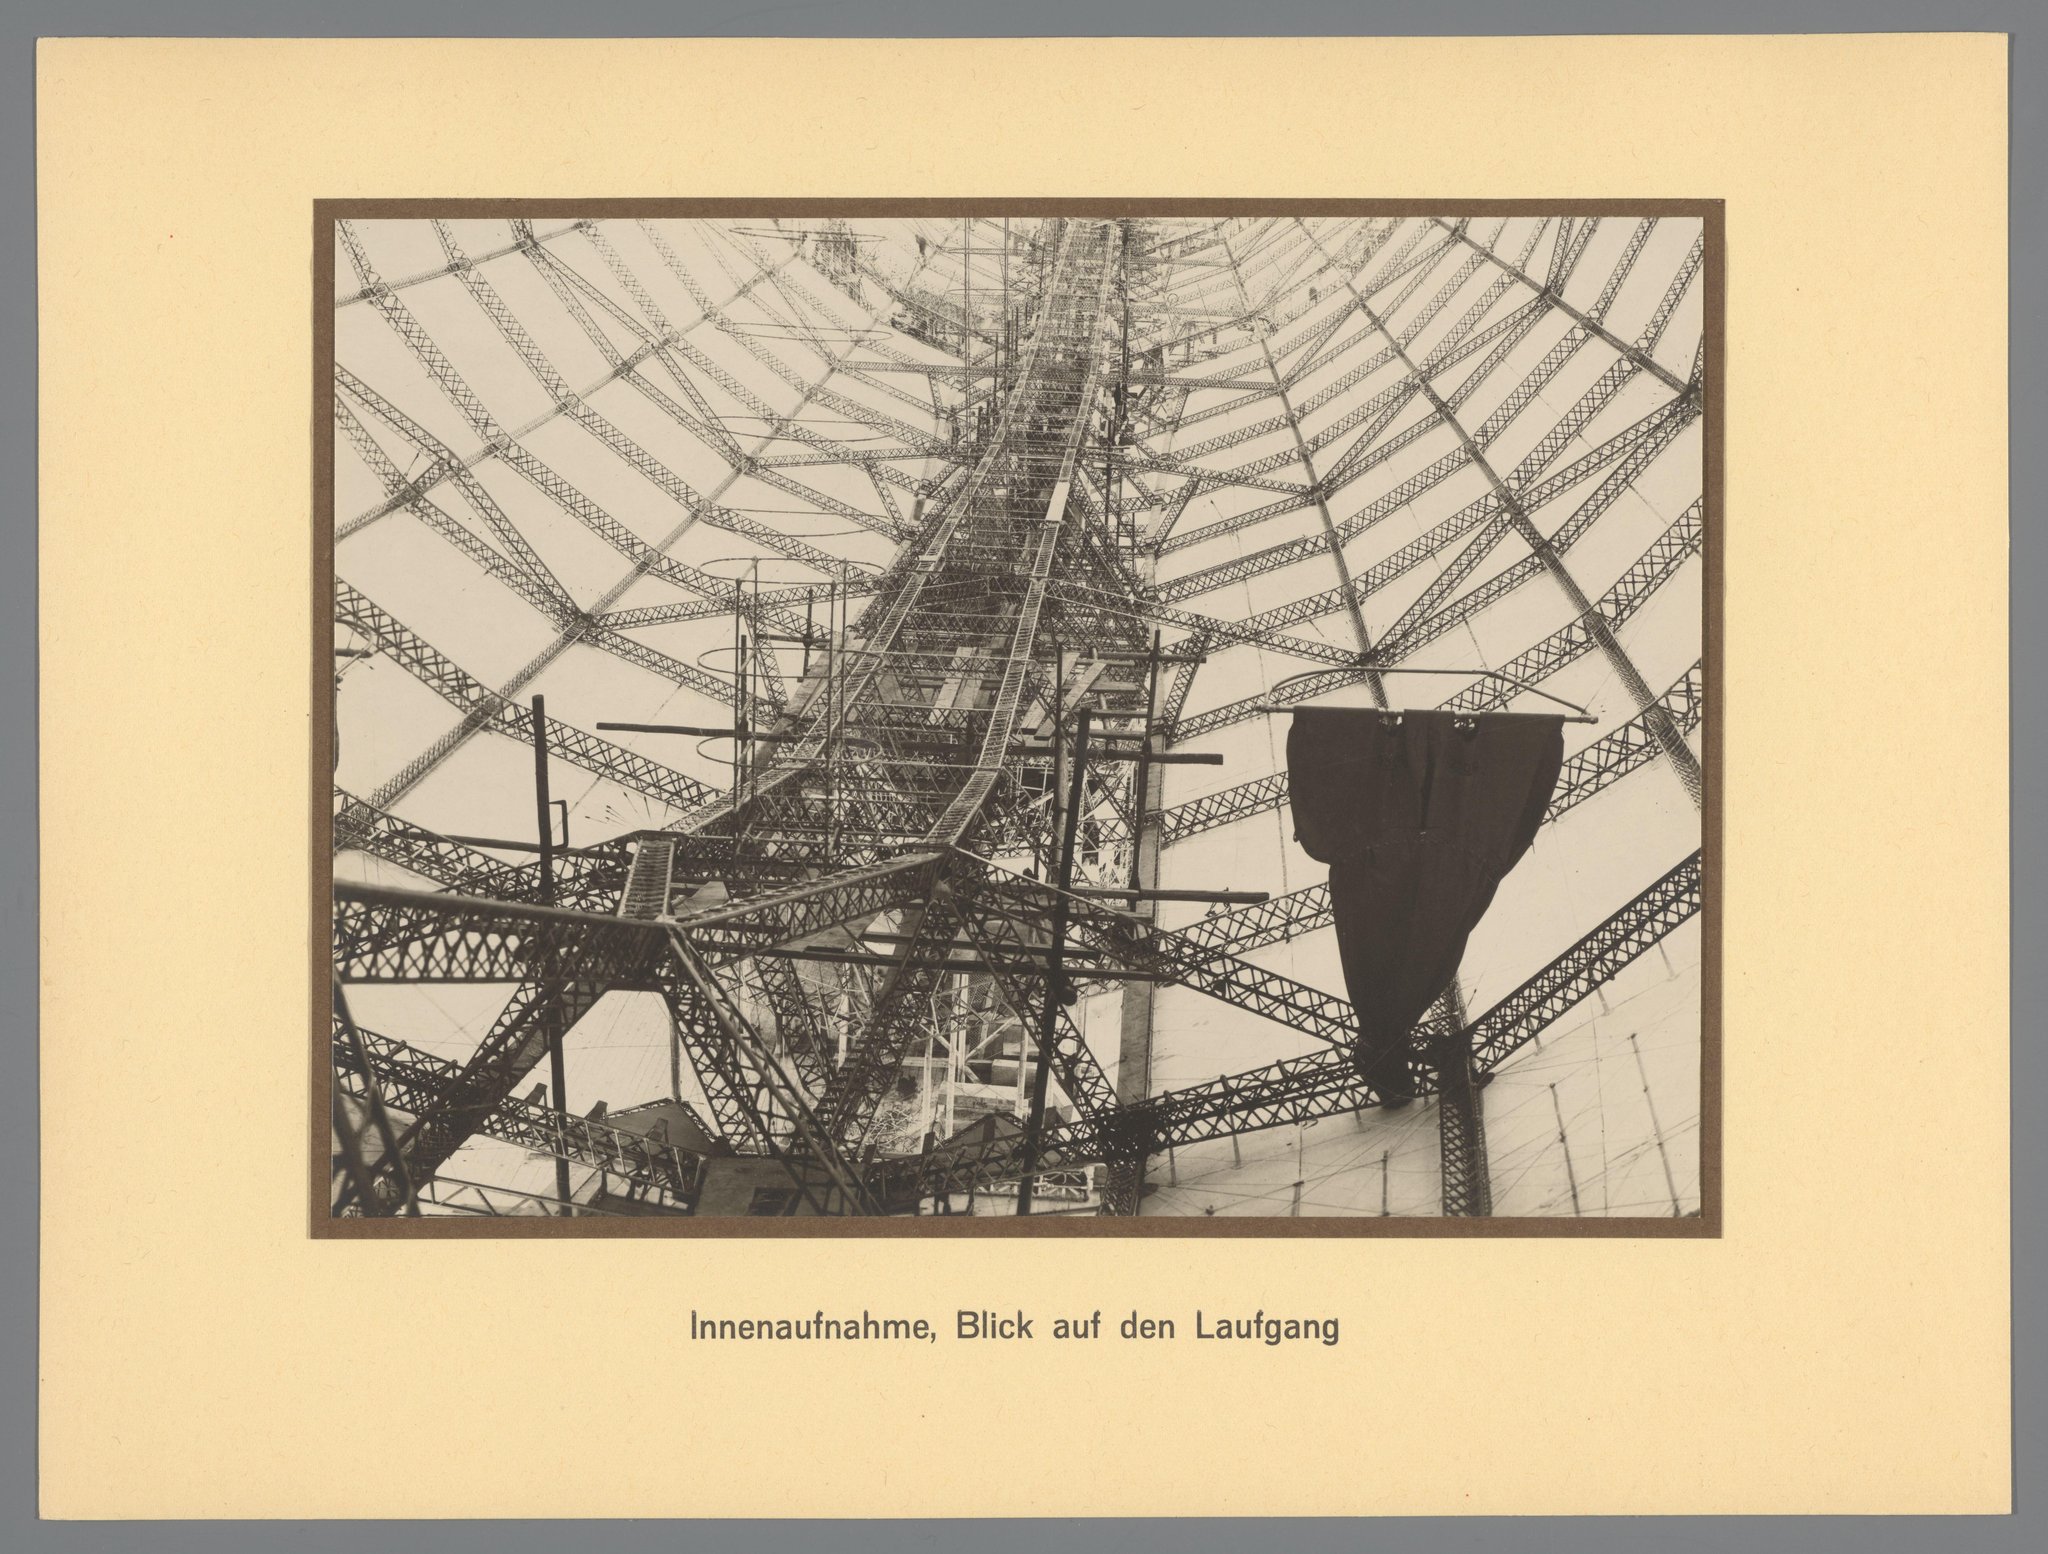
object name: photograph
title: Innenaufname, BLick auf den Laufgang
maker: Anonymous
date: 1924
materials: cardboard, photographic support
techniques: gelatin silver print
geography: germany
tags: 46c35 airship, zeppelin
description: Loopgang in het interieur van de zeppelin. Onderdeel van een map twintig productfoto's van het Zeppelinluchtschip LZ 126.